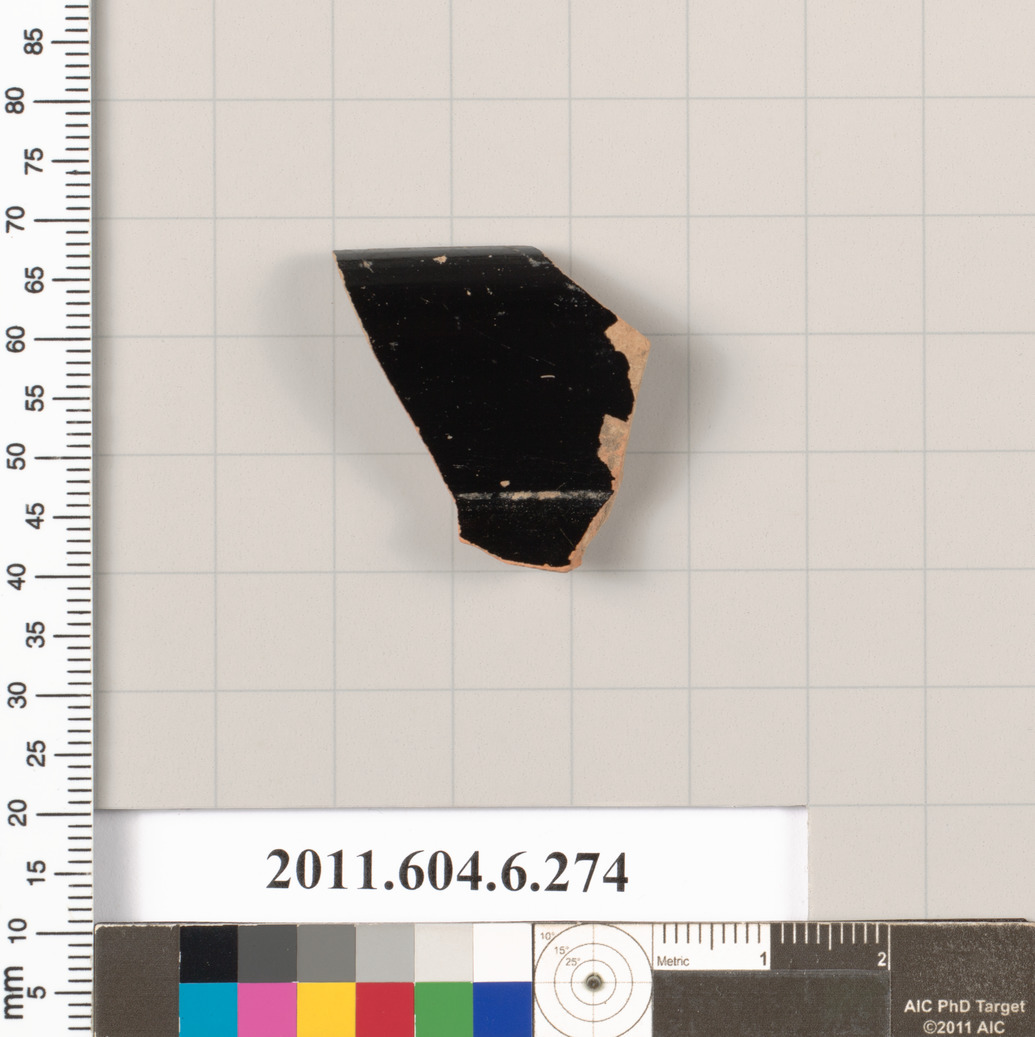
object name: undetermined open shape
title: Terracotta rim fragment of an open shape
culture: greek, attic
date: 500-401 BCE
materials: terracotta